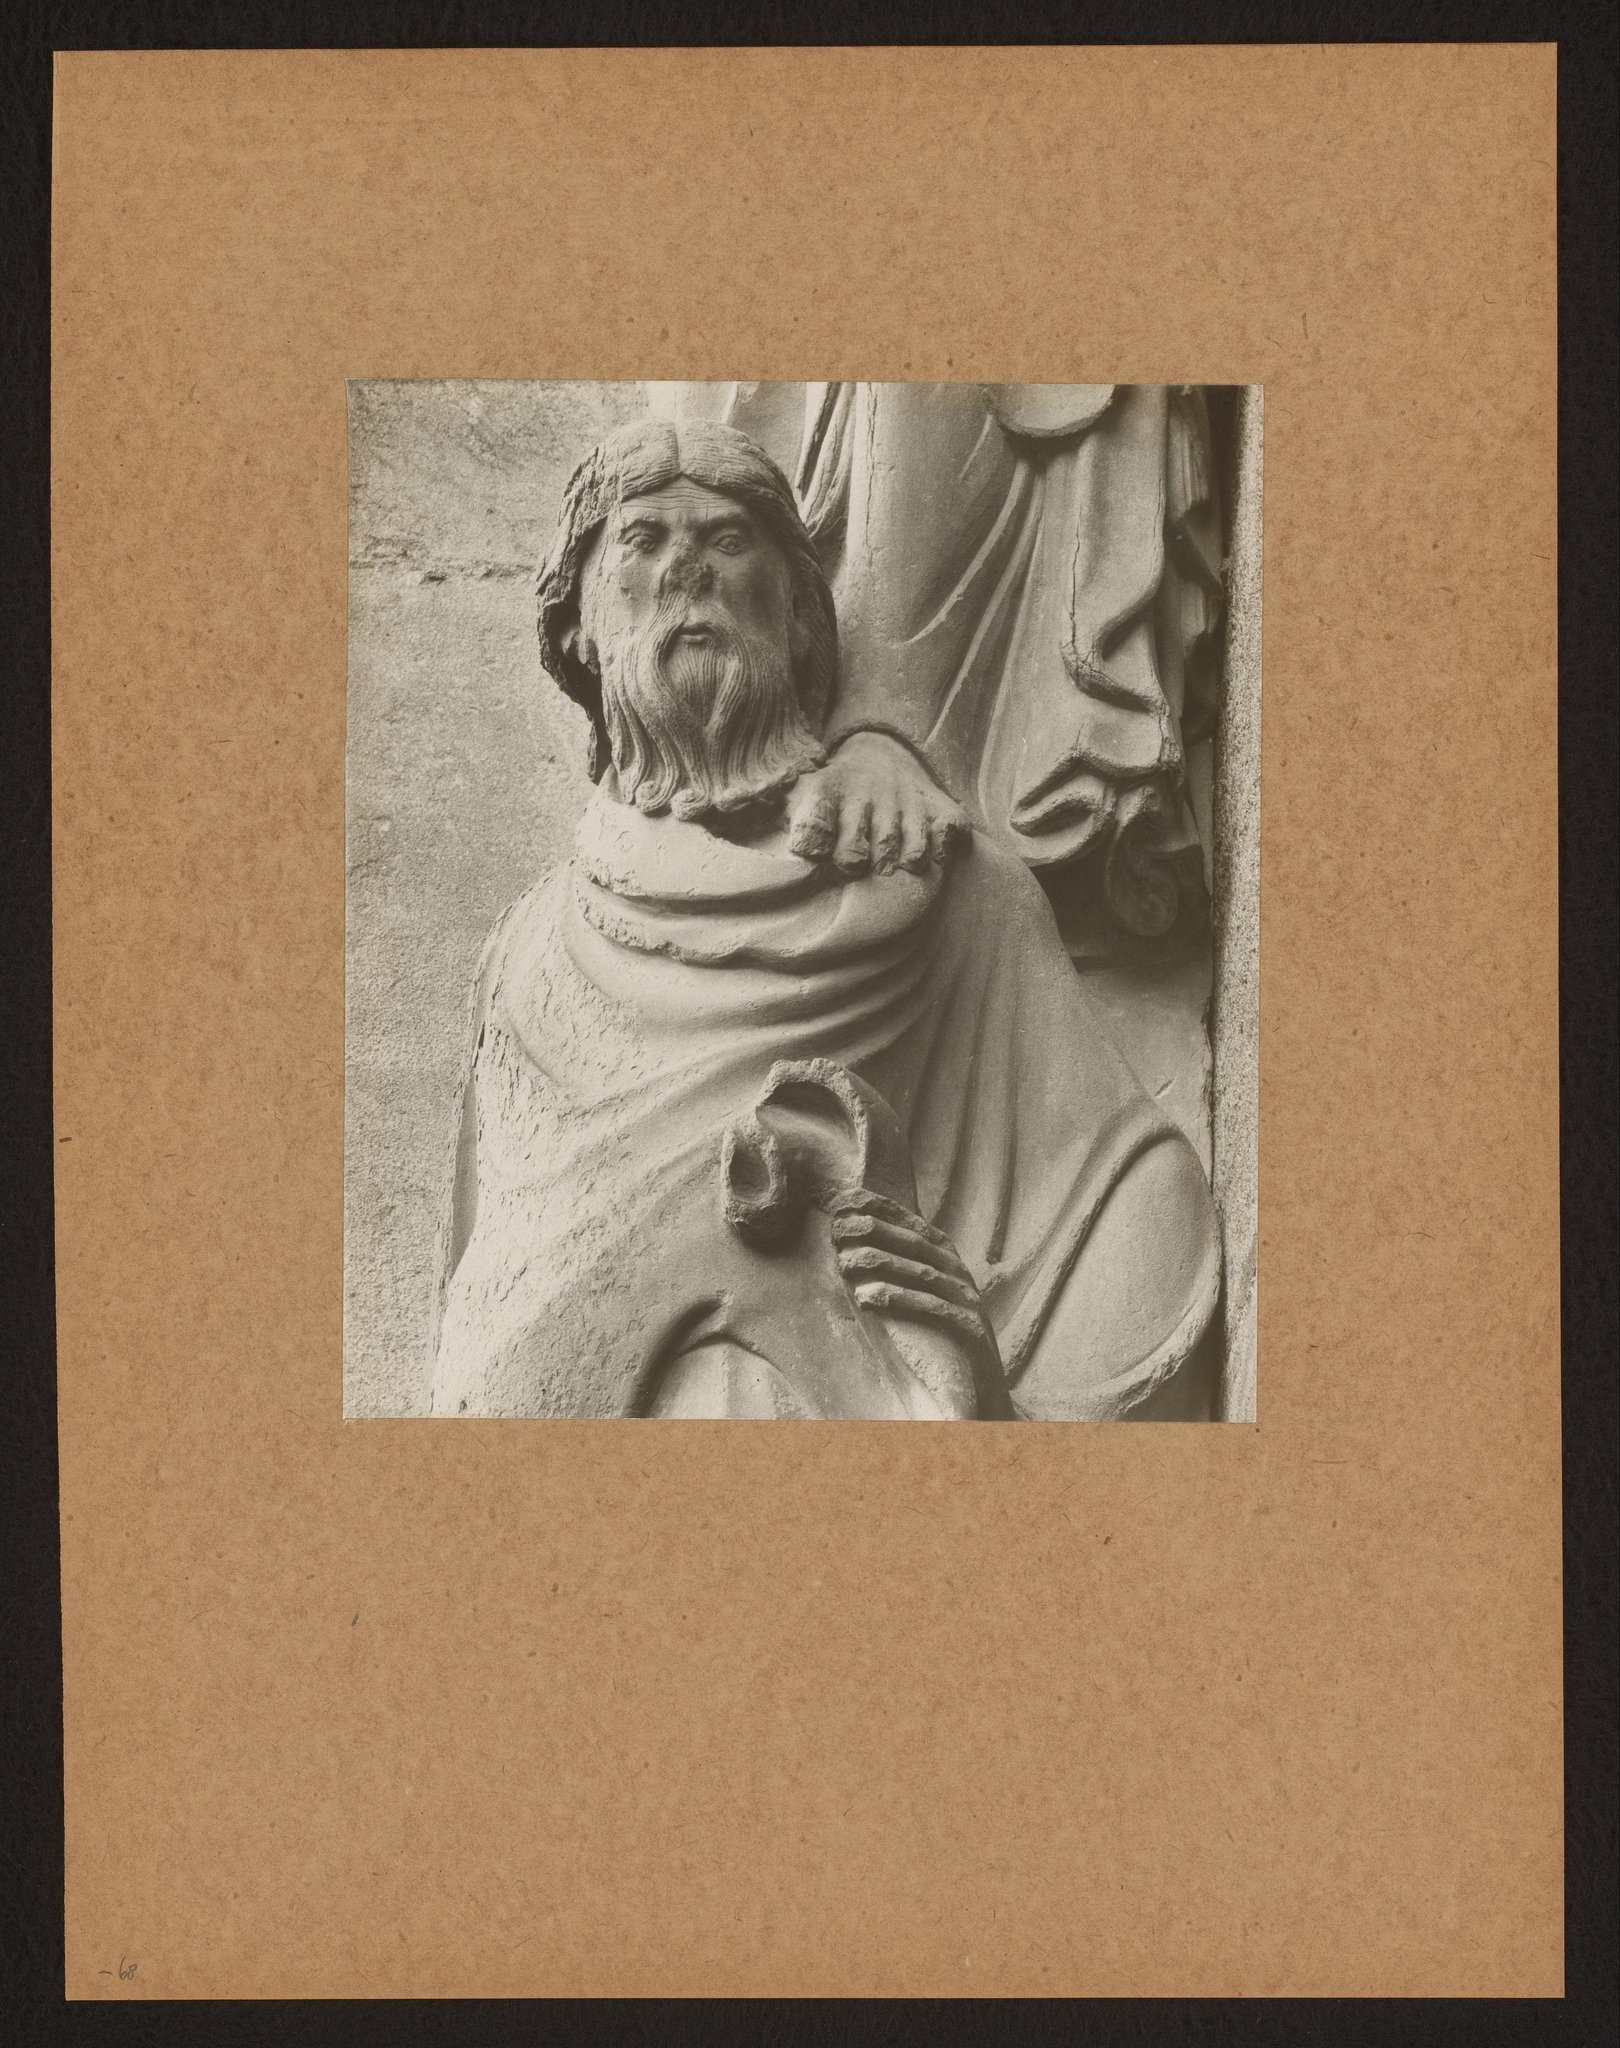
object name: album leaf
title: Detail van de Fürstenportal in de dom van Bamberg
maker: Anonymous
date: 1900-1920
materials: paper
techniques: gelatin silver print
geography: bamberg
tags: church (exterior)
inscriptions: number: ‘70’